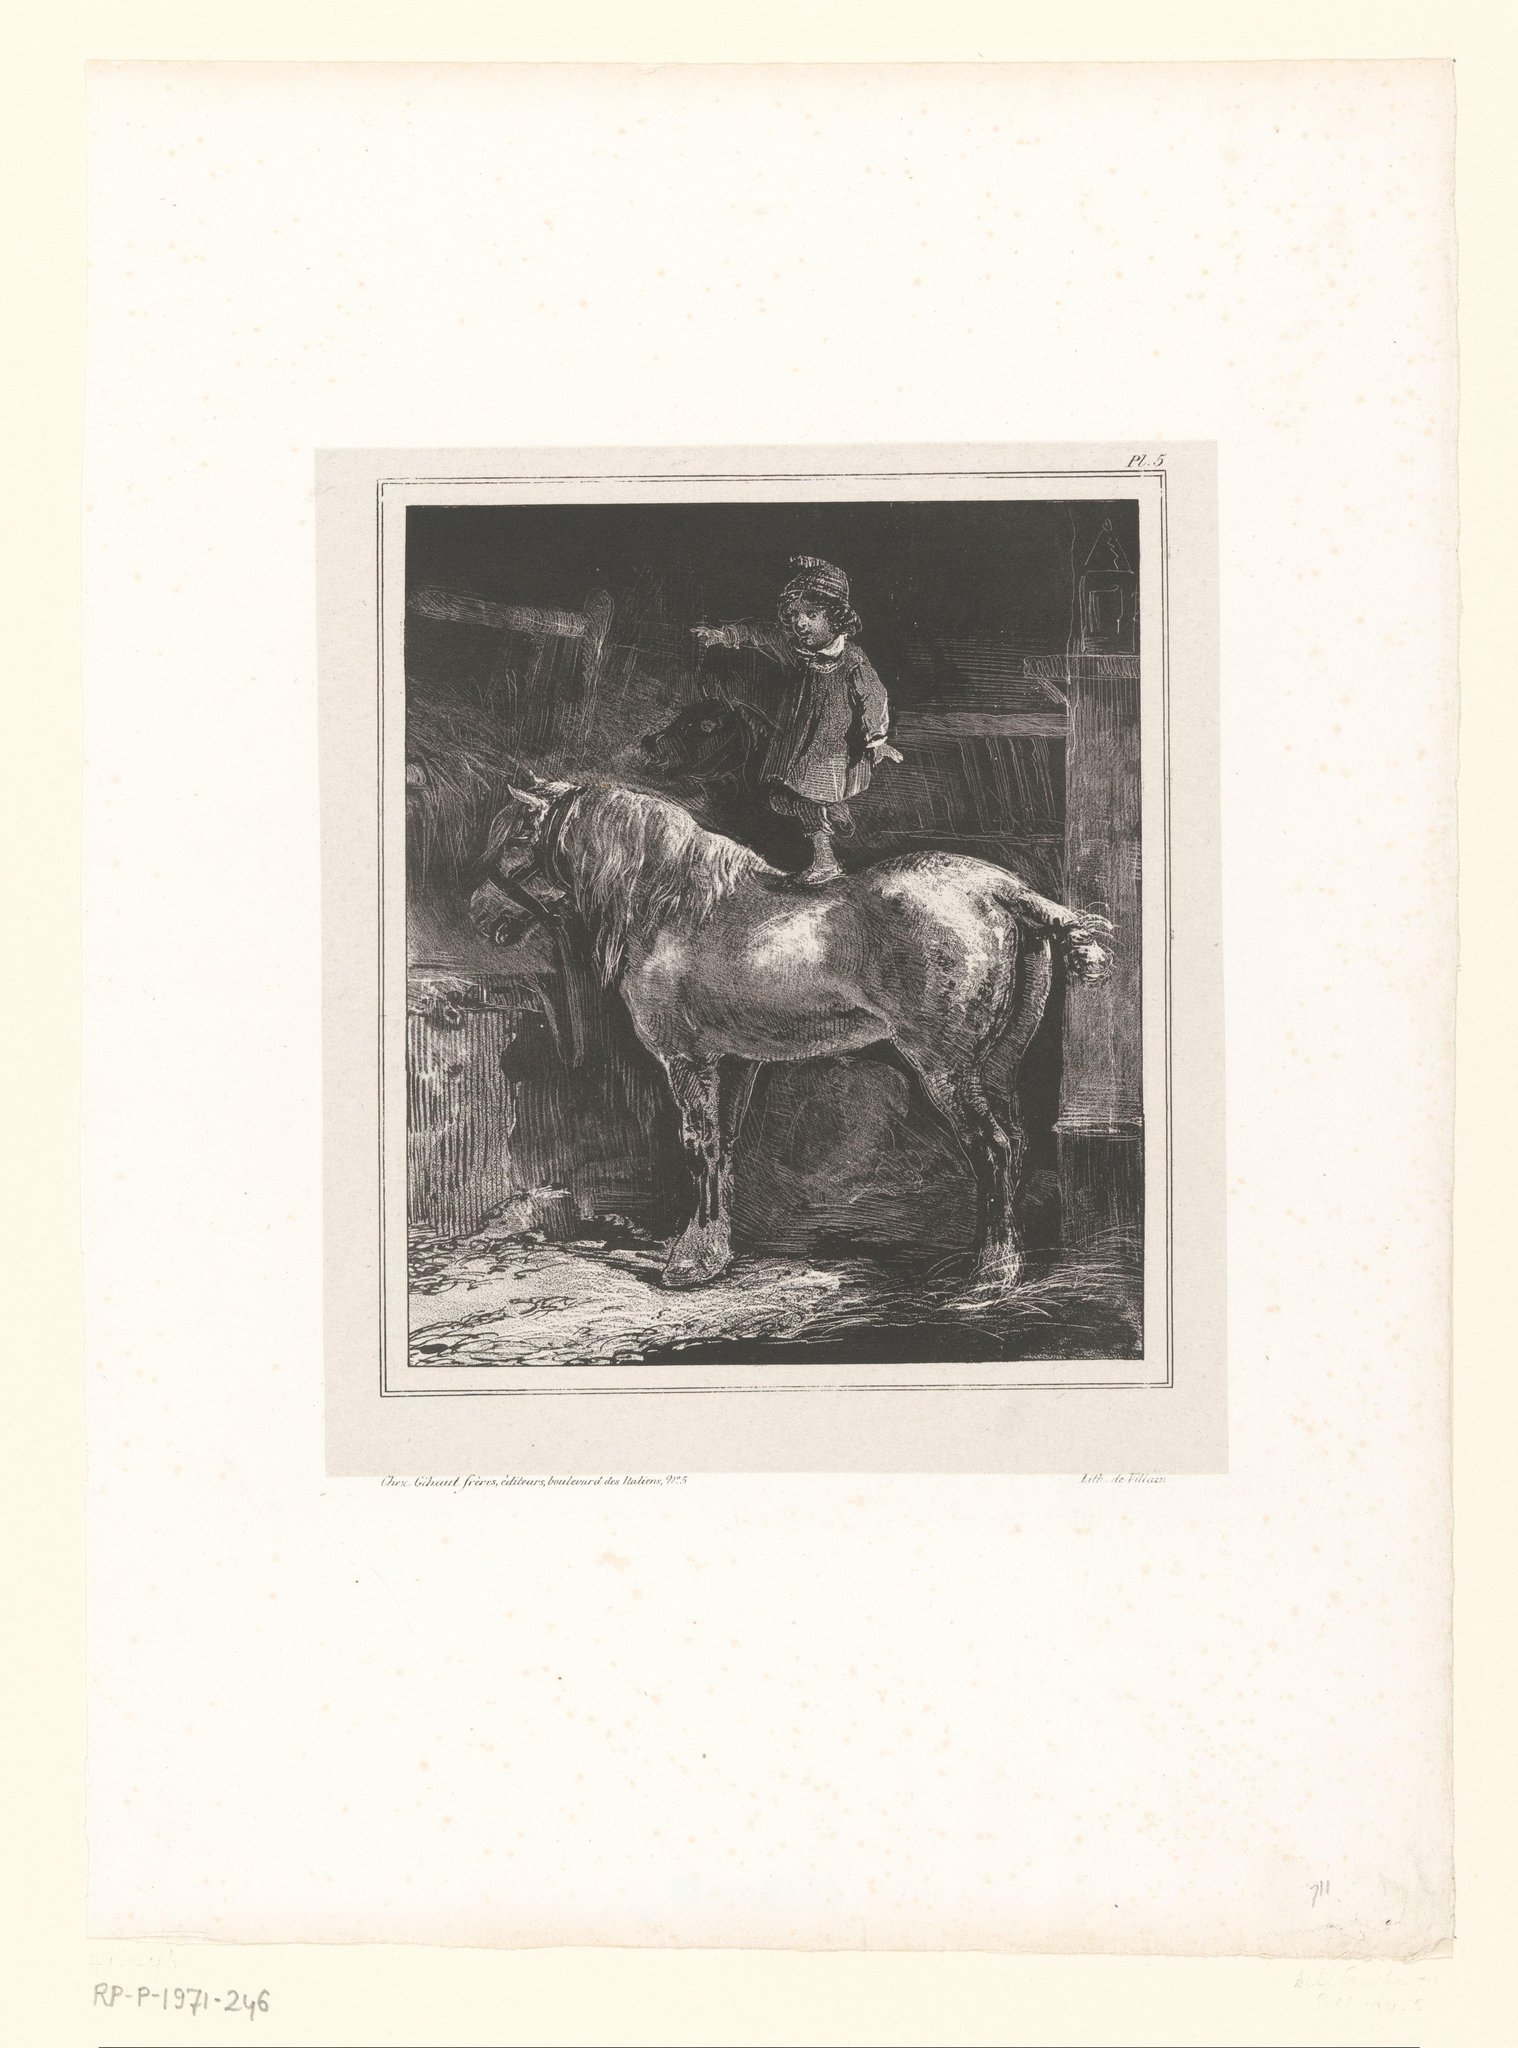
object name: print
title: Petit enfant debout sur un cheval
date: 1828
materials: paper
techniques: lithograph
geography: paris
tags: child, child playing with animals, horse, stall, stable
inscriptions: collector's mark: Lugt 2760, collector's mark: Lugt 2228a